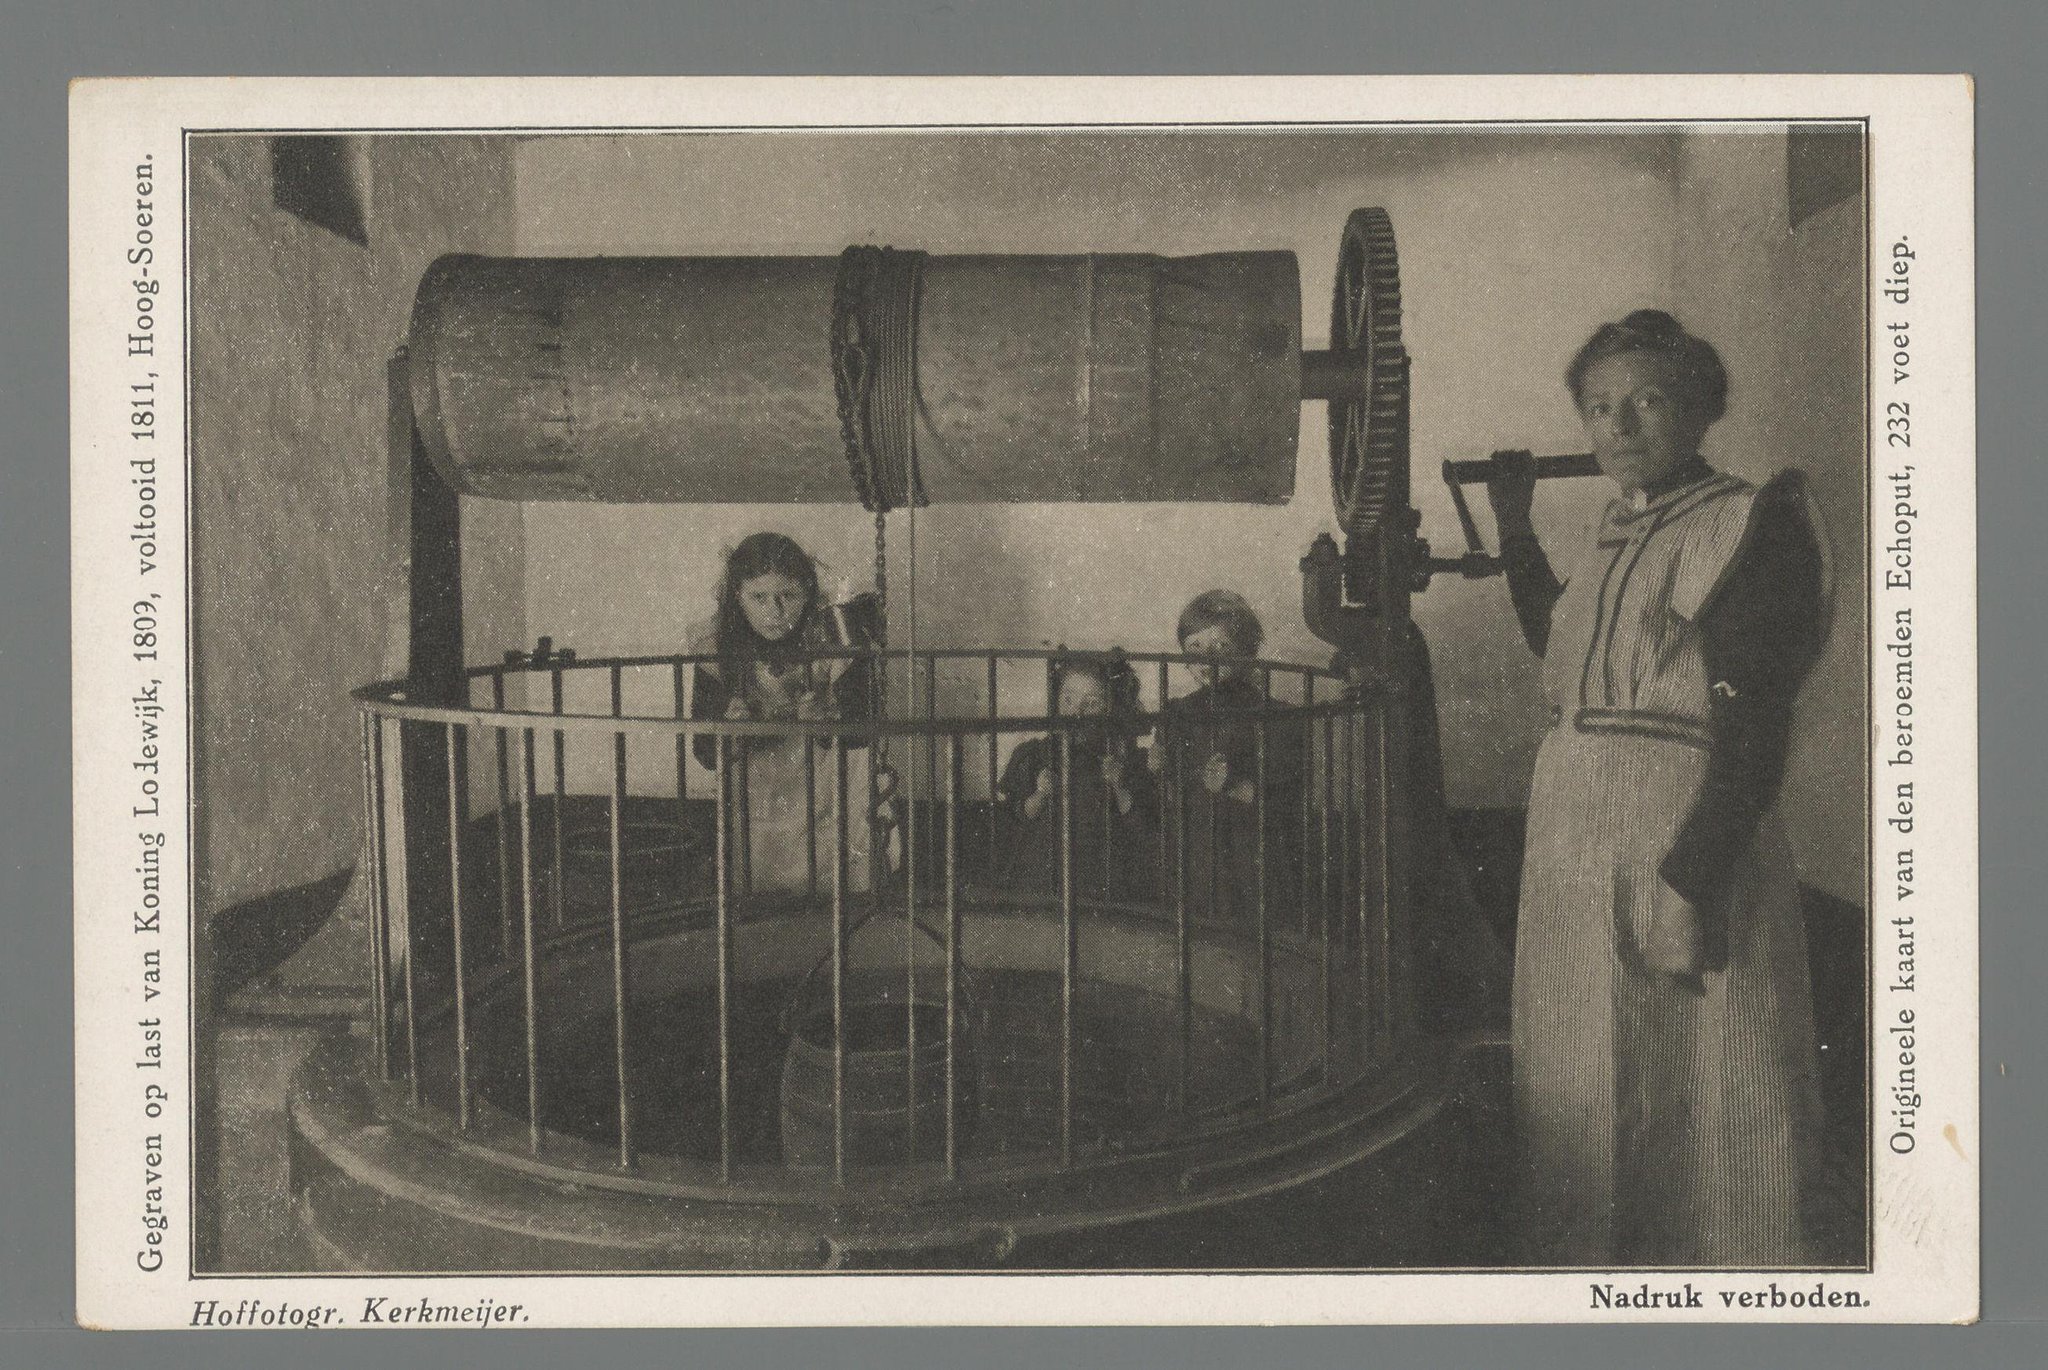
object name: ansichtkaart, prentbriefkaart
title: Gegraven op last van Koning Lodewijk, 1809, voltooid 1811, Hoog-Soeren. Origineele kaart van den beroemden Echoput, 232 voet diep.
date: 1905-1920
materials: cardboard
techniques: autotype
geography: hoog-soeren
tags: well